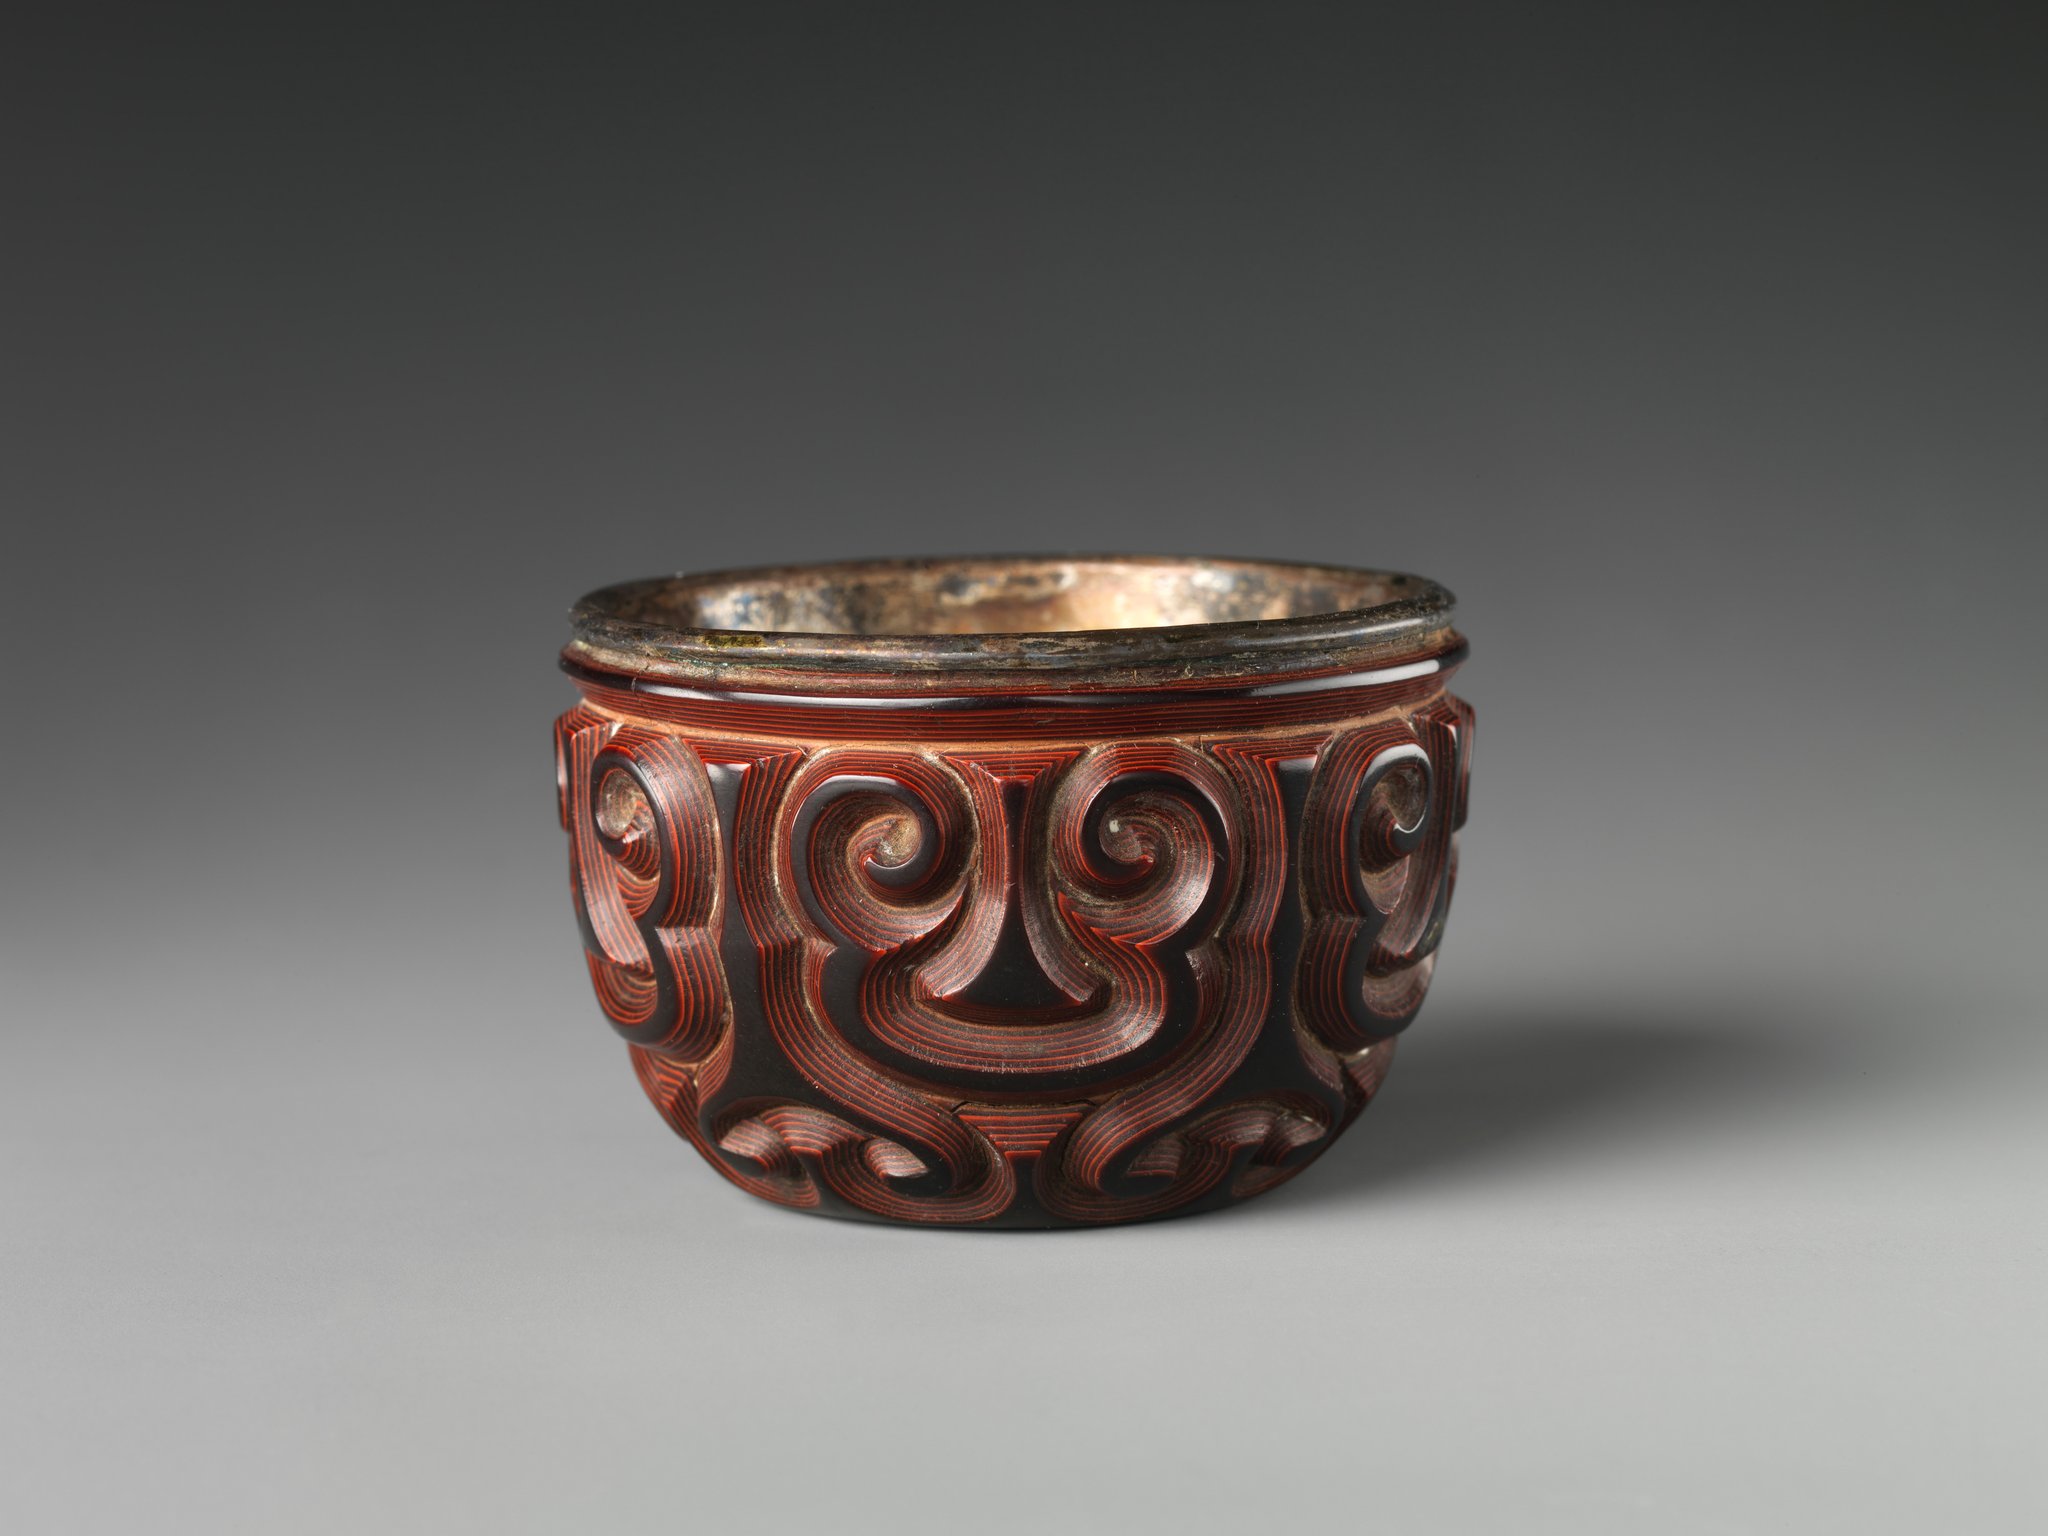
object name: cup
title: Guri lacquer cup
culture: chinese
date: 1271-1368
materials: lacquer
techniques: carving